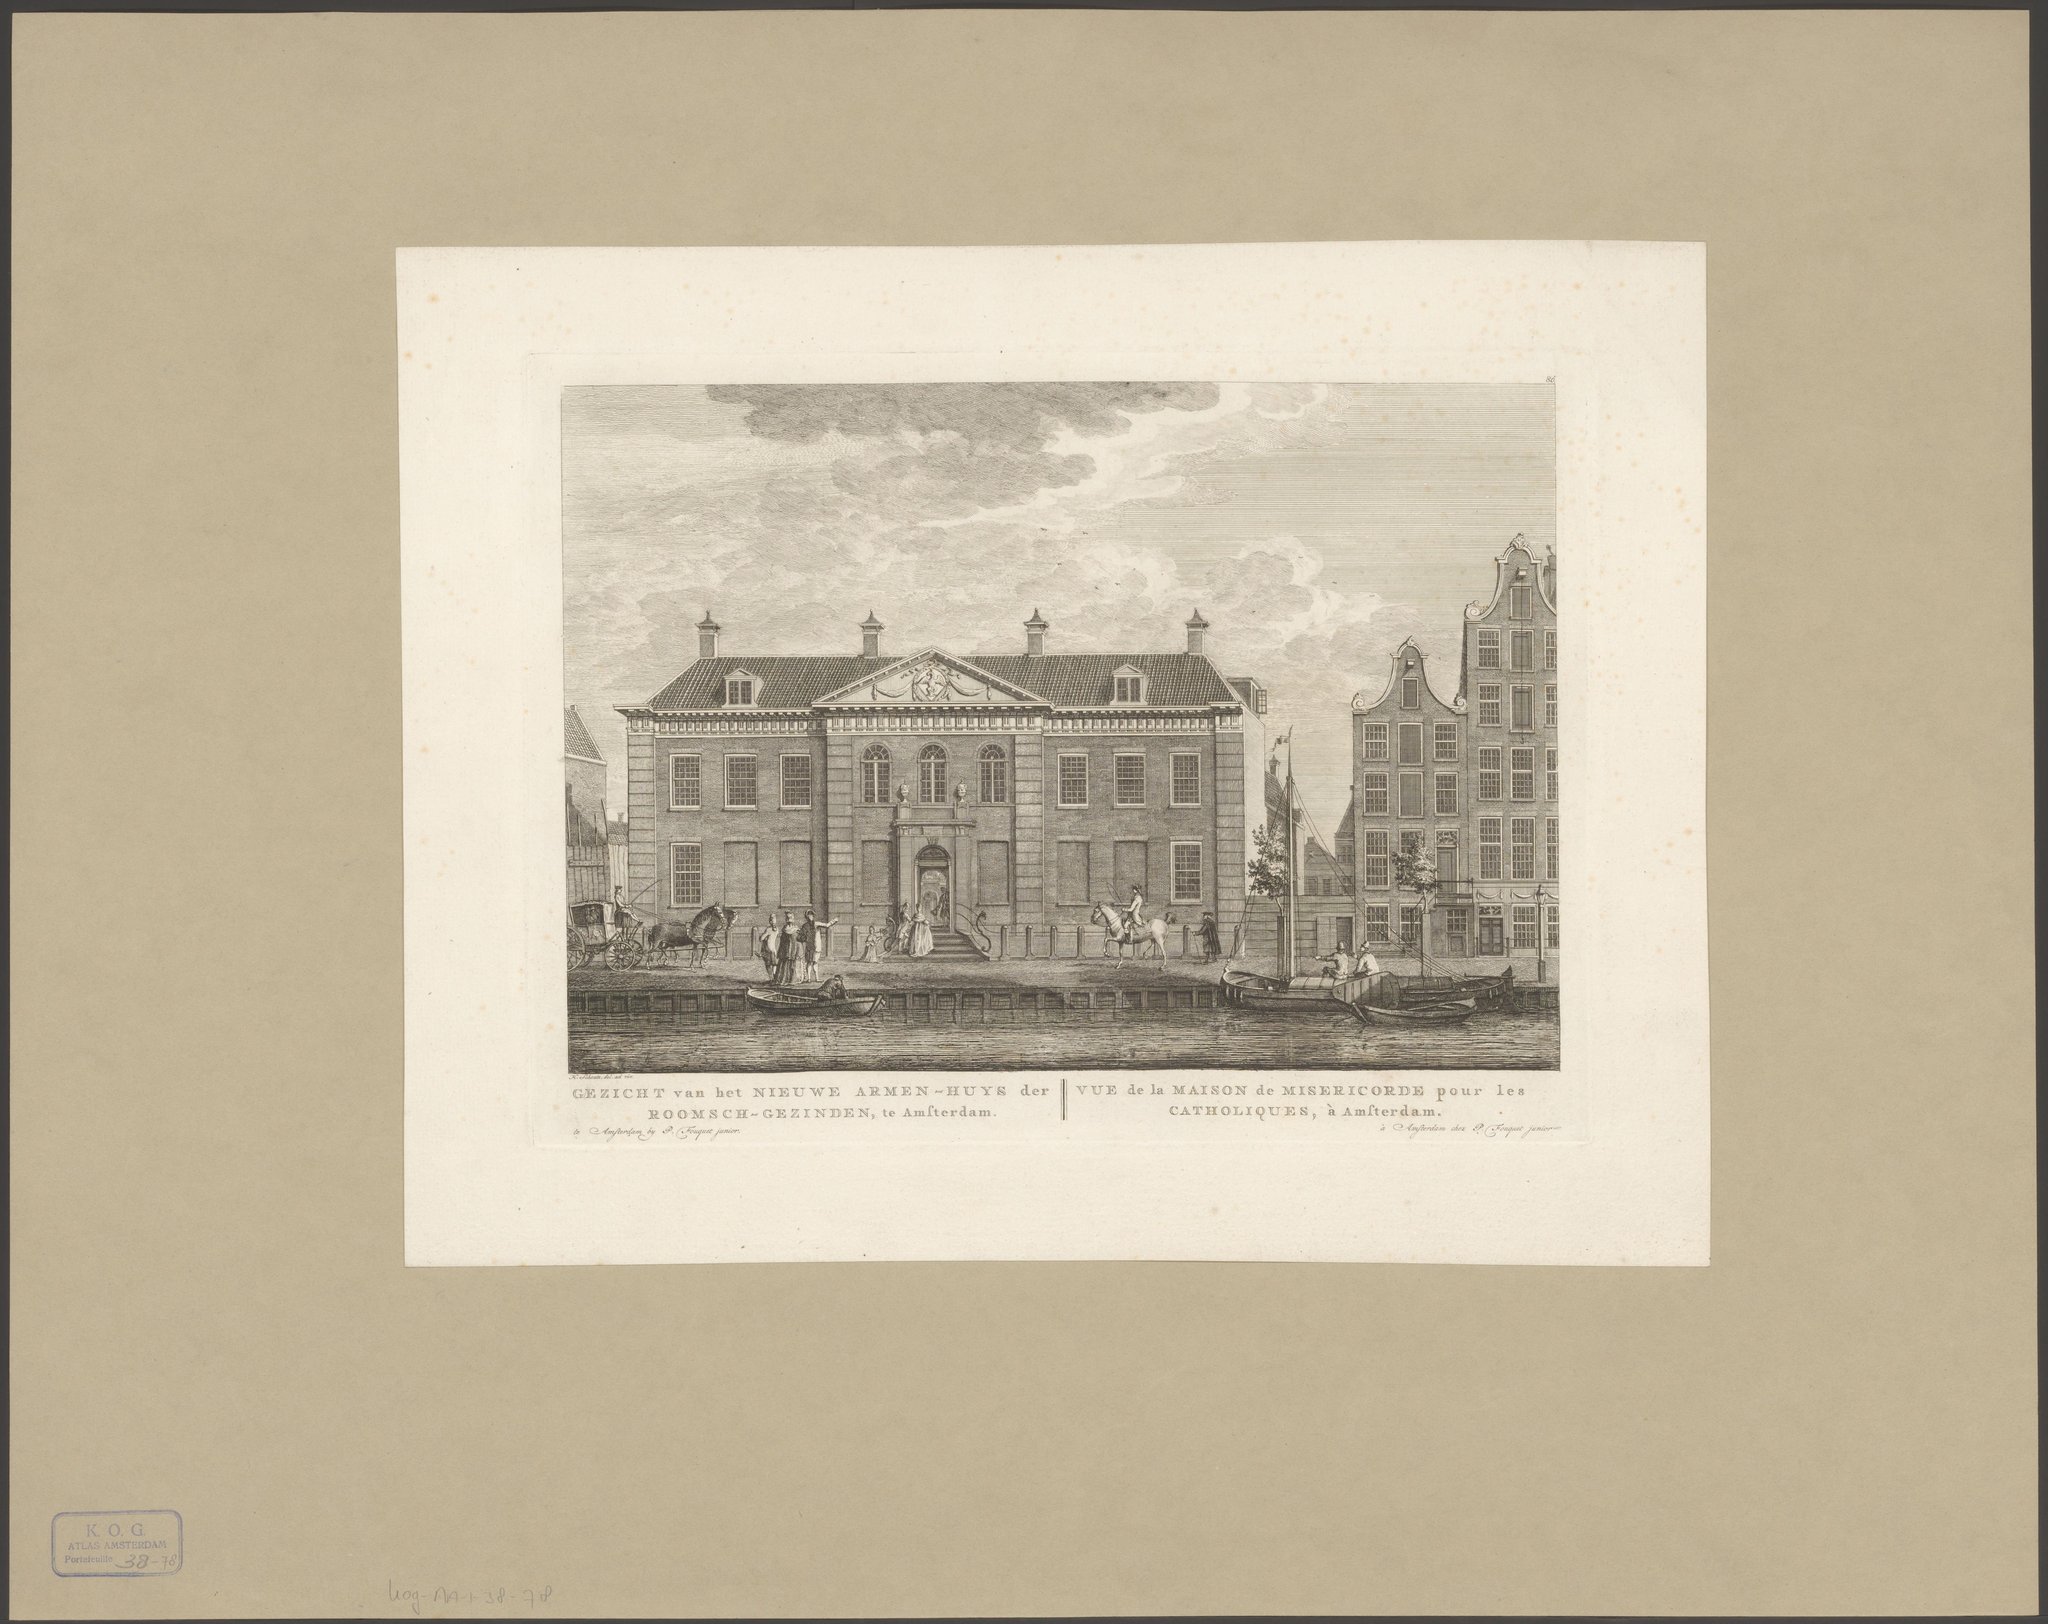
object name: print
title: Gezicht op het Gebouw van Barmhartigheid te Amsterdam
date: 1770-1783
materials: paper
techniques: engraving, etching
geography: amsterdam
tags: canals, waters (in city) (+ city(-scape) with figures, staffage), old-people's home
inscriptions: collector's mark: Lugt 1641b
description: Vanaf 1760 gaf Pierre Fouquet stadsgezichten van Amsterdam naar tekeningen van verschillende kunstenaars uit. Deze prenten werden aanvankelijk los verkocht. Later werden ze samengebonden verkocht in verschillende volgordes en aantallen in: (1). Afbeeldingen van de wyd-vermaarde koopstad Amsterdam benevens des zelvs voornaamste gebouwen en gezigten alle naar het leeven getekend / Receuil des edifices les plus considerables et des plus belles vues, de la fameuse ville d'Amsterdam, dessinées d'après nature. Amsterdam: Pierre Fouquet, 1778-1783. Deze 'uitgave' bestond waarschijnlijk alleen uit een titelblad en inhoudsopgave van de tot dusver 100 uitgegeven prenten, die de koper zelf aan zijn of haar reeds verzamelde prenten kon toevoegen. De hoeveelheid en volgorde van prenten verzameld onder deze titel verschilt dus sterk. (2). Nieuwe atlas, van de voornaamste gebouwen en gezigten der stad Amsterdam, met derzelver beknopte beschryvingen. 2 dln. Amsterdam: Daniël Jean Changuion en Petrus den Hengst [in opdracht van Pierre Fouquet], 1783. Ook werden er door verschillende uitgevers tussen 1788 (Amsterdam: Petrus Conradi) en 1805 (Amsterdam: Evert Maaskamp) heruitgaven gepubliceerd.